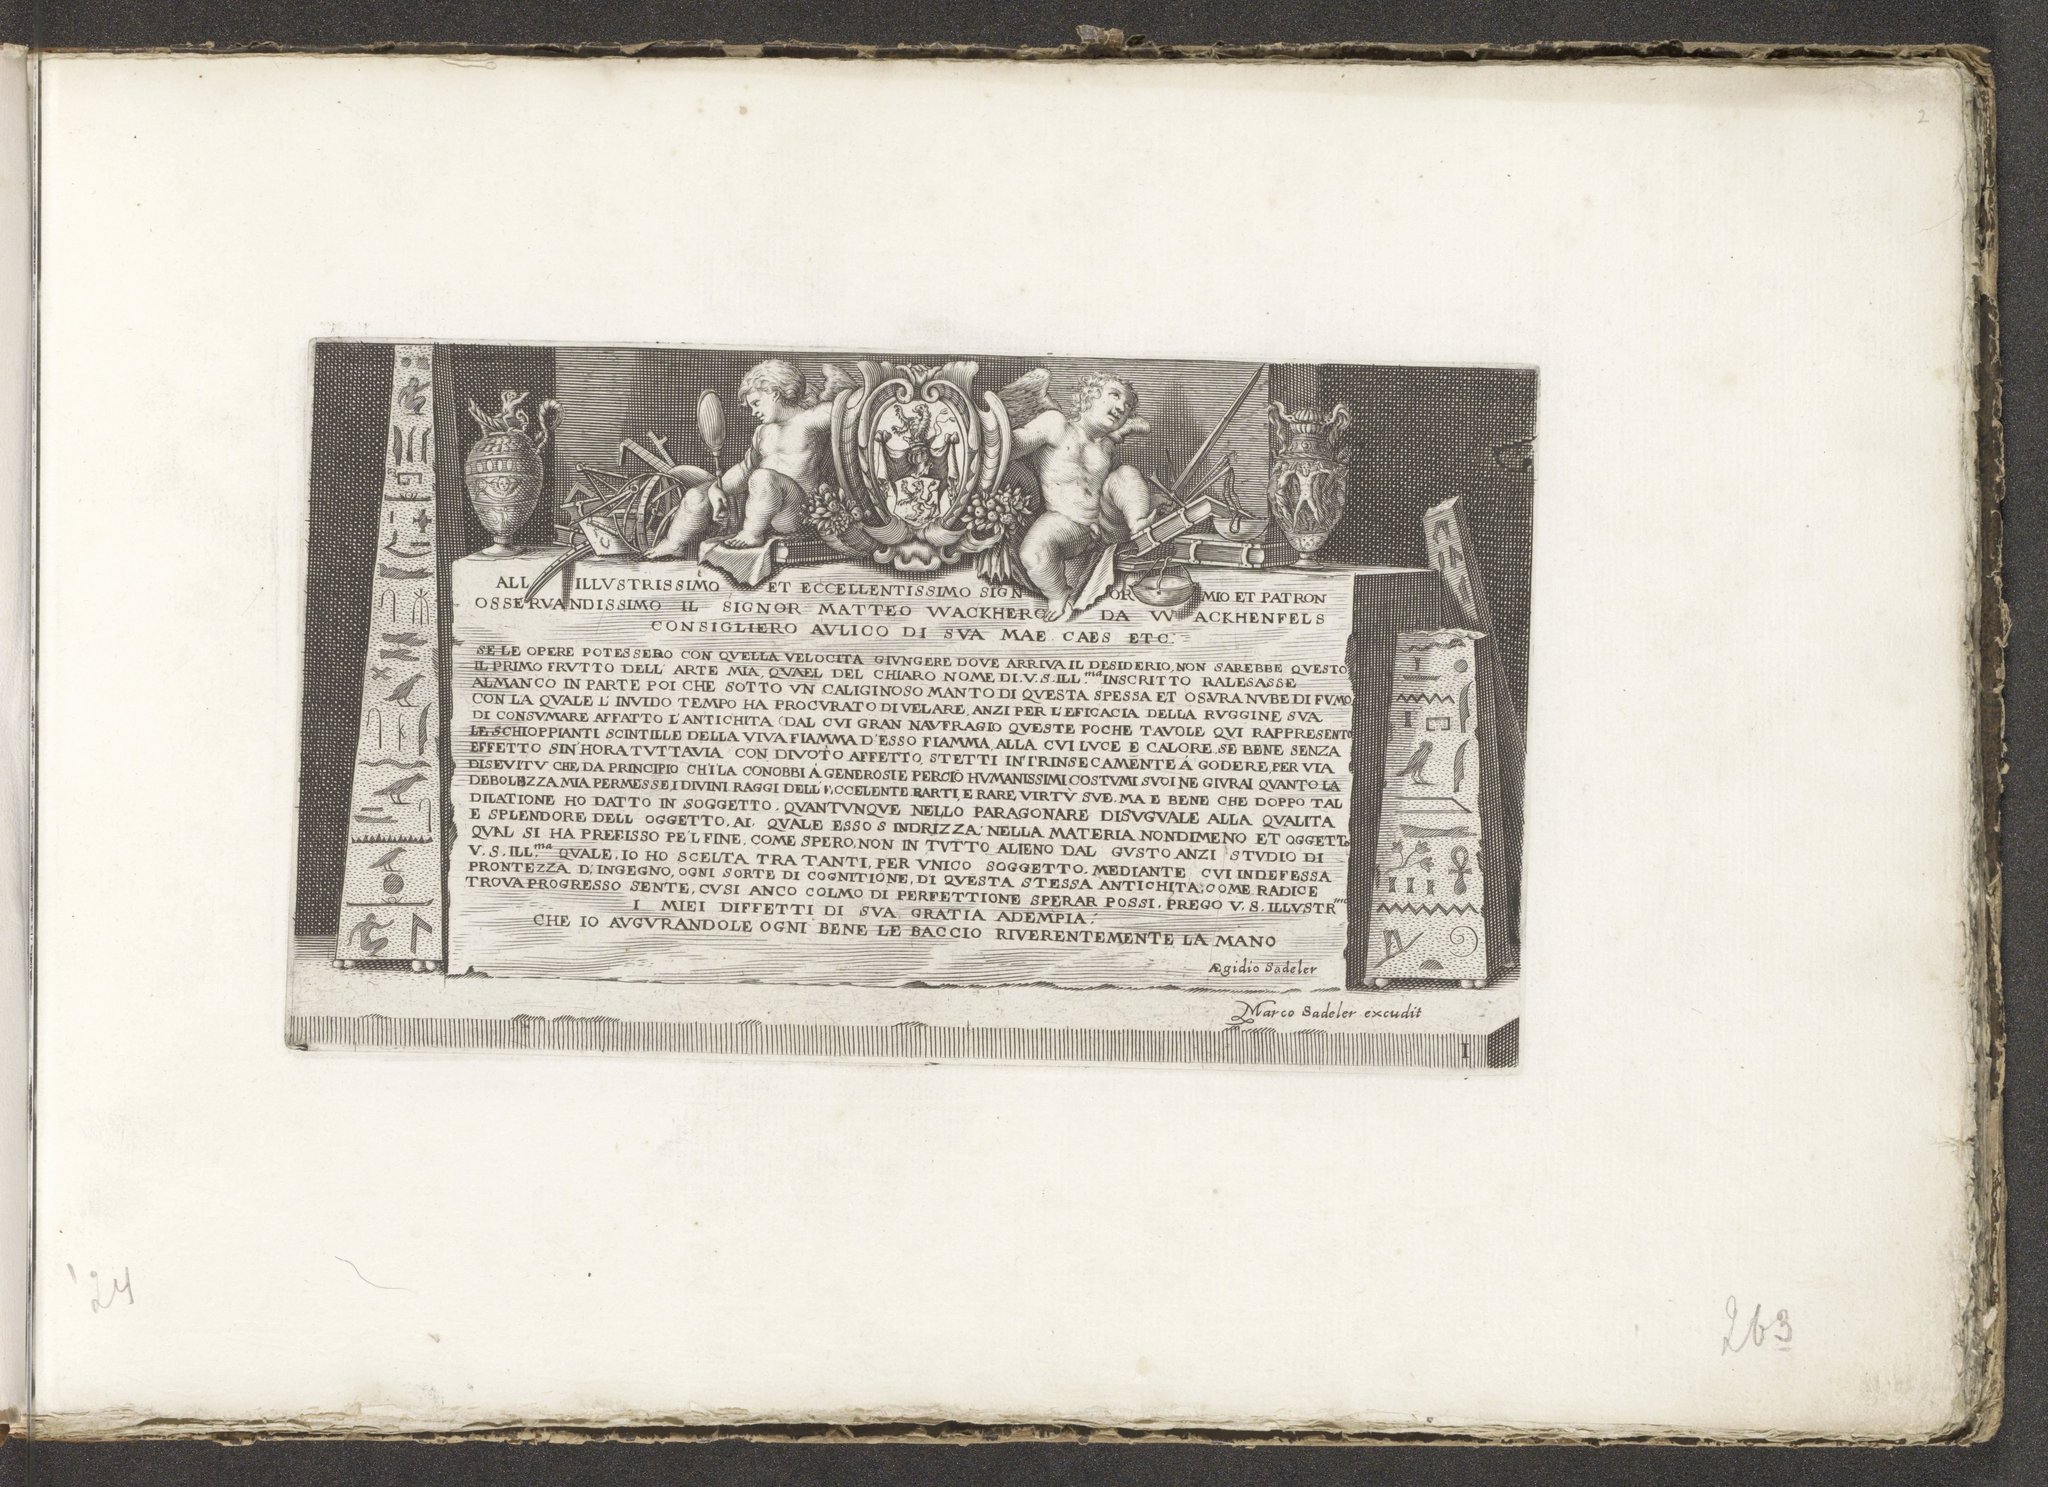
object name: album leaf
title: Stenen tablet geflankeerd door obelisken met hiërogliefen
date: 1680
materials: paper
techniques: engraving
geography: rome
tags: obelisk, needle, clay tablet, stone tablet, measuring-instruments, book, cupids: 'amores', 'amoretti', 'putti', armorial bearing, heraldry, egyptian hieroglyphs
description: Dedicatieprent met de tekst weergegeven op een steen, geflankeerd door een obelisk met hiërogliefen. Op de steen twee vazen. Twee putti met een spiegel en zwaard en naast zich meetinstrumenten en boeken houden een wapenschild vast. De prent maakt deel uit van een album.